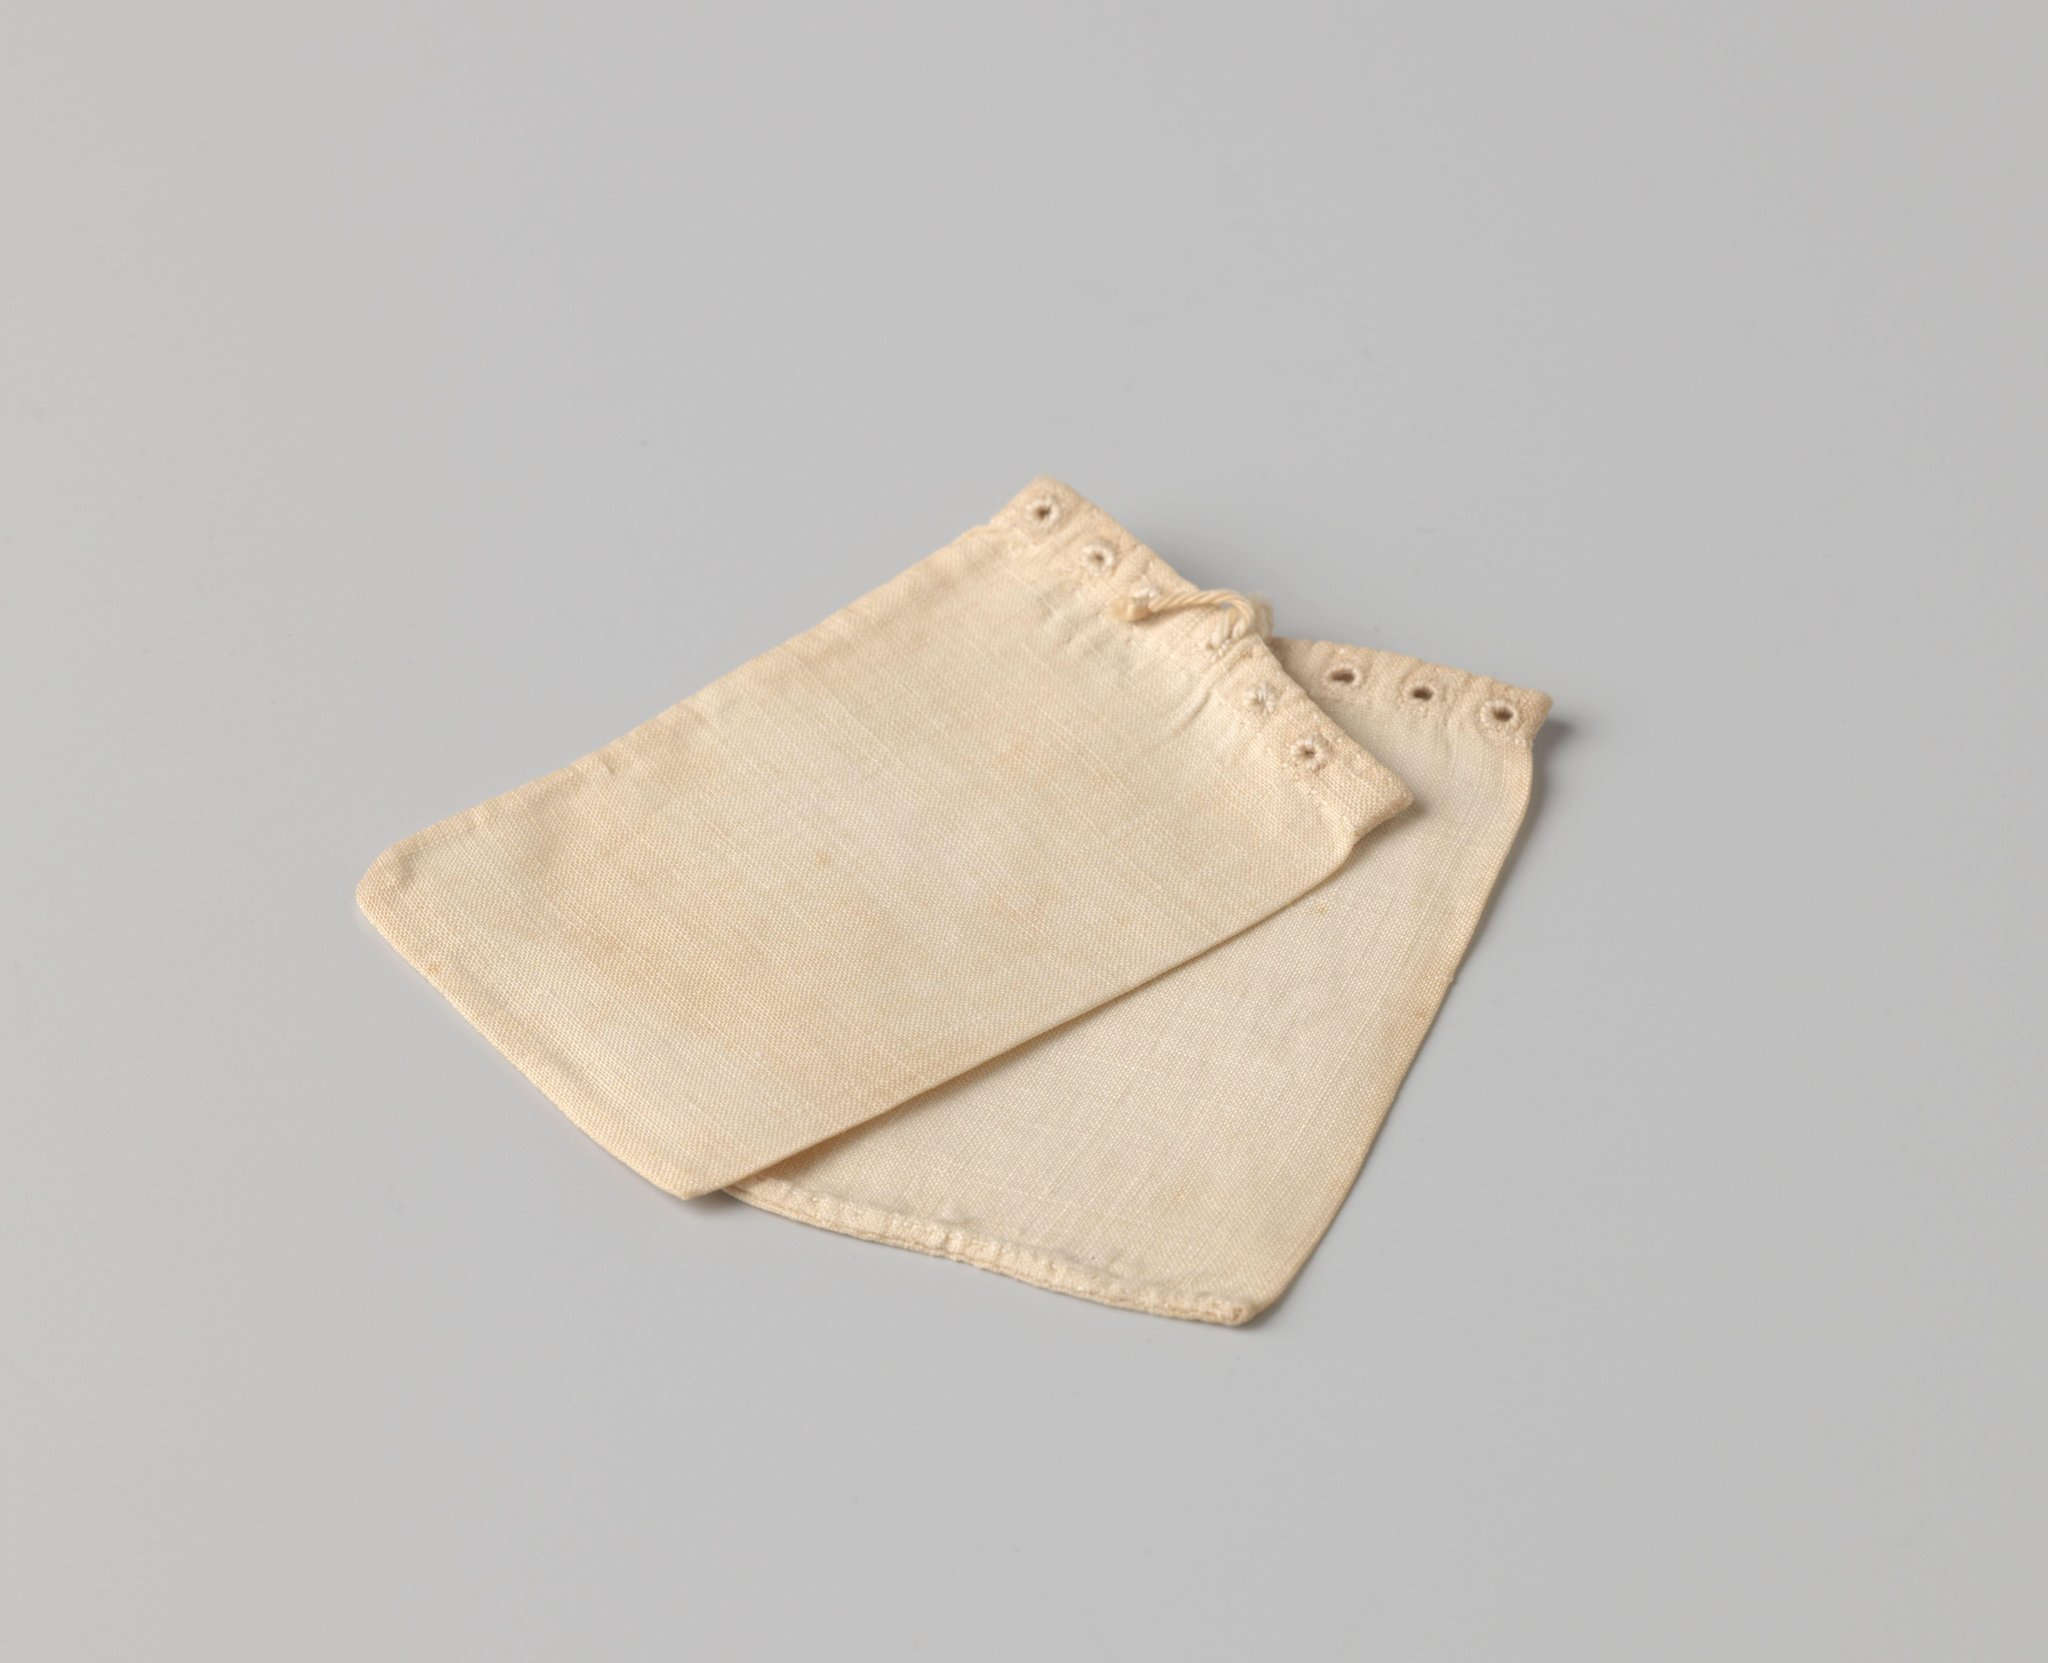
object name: sloop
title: Sloop met koordsluiting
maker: Anonymous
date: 1750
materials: linen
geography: netherlands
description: Sloop voor kussen, aan korte zijde voorzien van zes gaten voor koordsluiting.